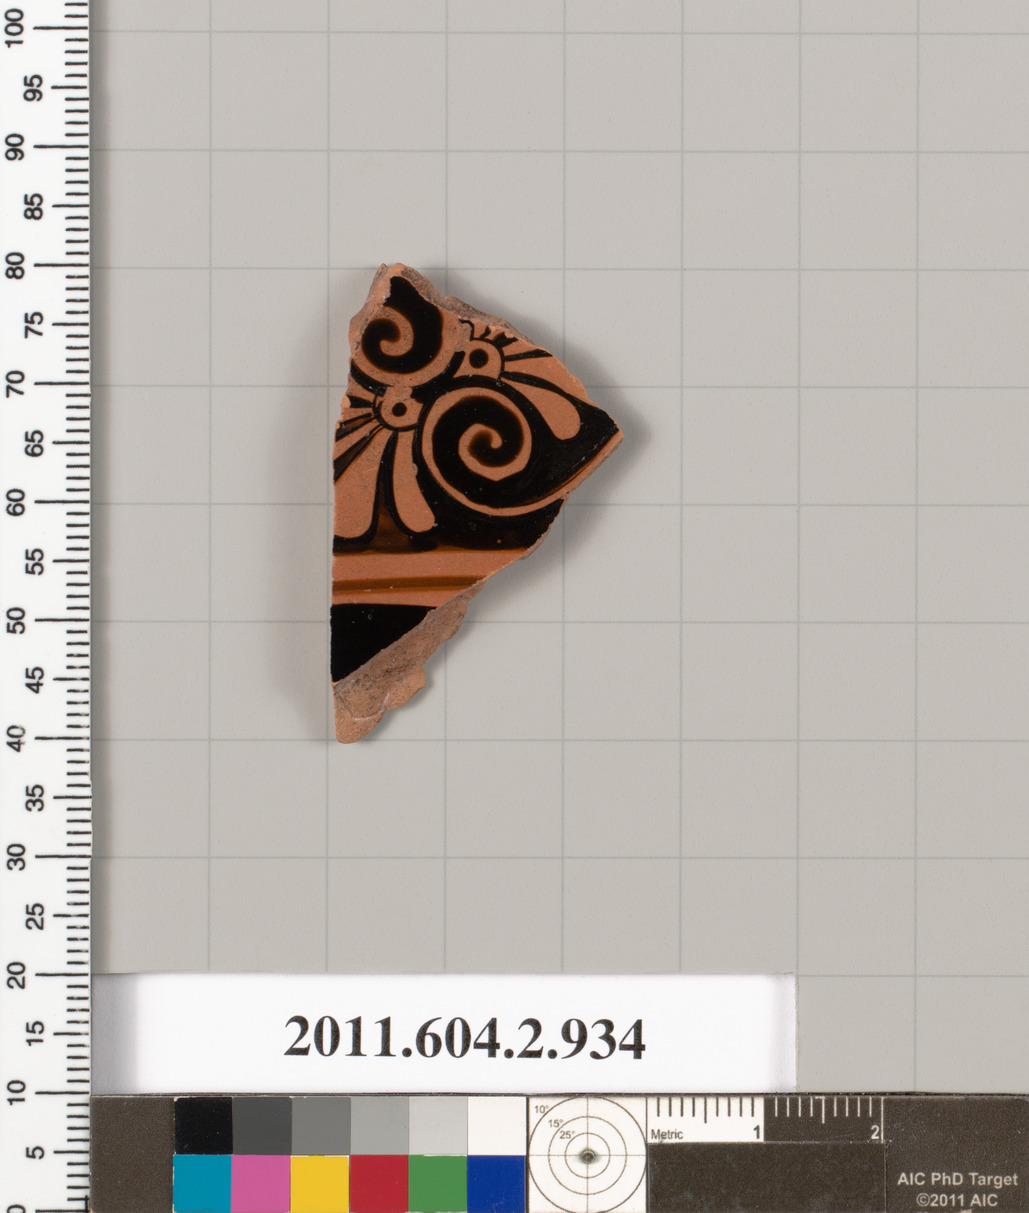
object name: kalpis fragment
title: Terracotta fragment of a hydria: kalpis (water jar)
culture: greek, attic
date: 460-450 BCE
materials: terracotta